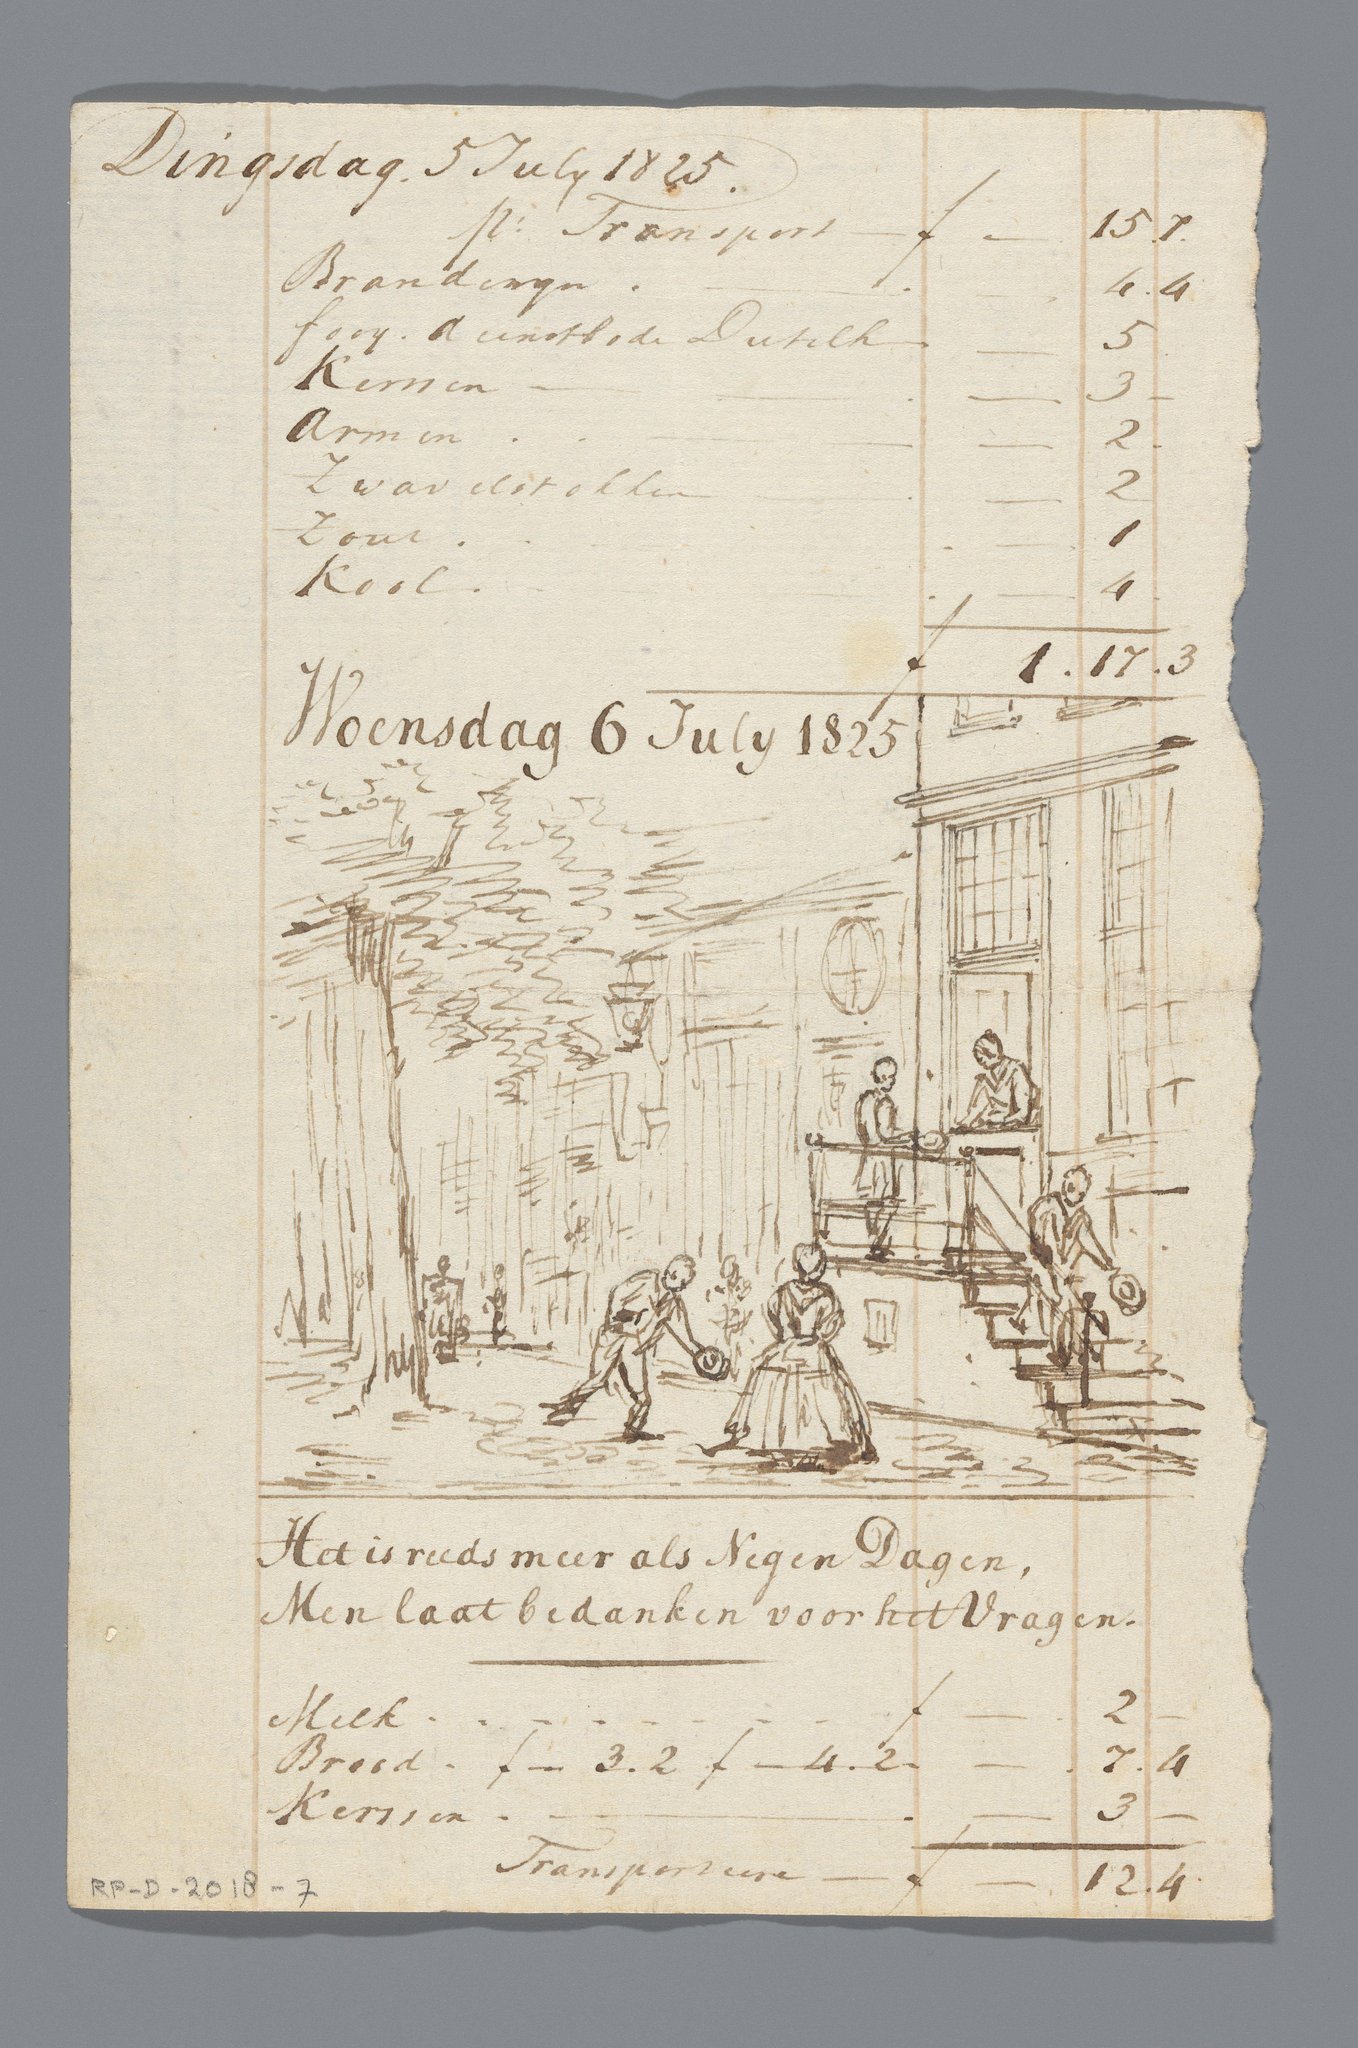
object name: document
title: Bladzijde uit een tweezijdig beschreven kasboekje, met tekening bij woensdag 6 juli 1825: stadstafereel met het op straat stellen van een belangrijke vraag van een man aan een vrouw.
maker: pieter ernst hendrik praetorius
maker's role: draughtsman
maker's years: 1791-1876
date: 1825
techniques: pen, writing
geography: amsterdam